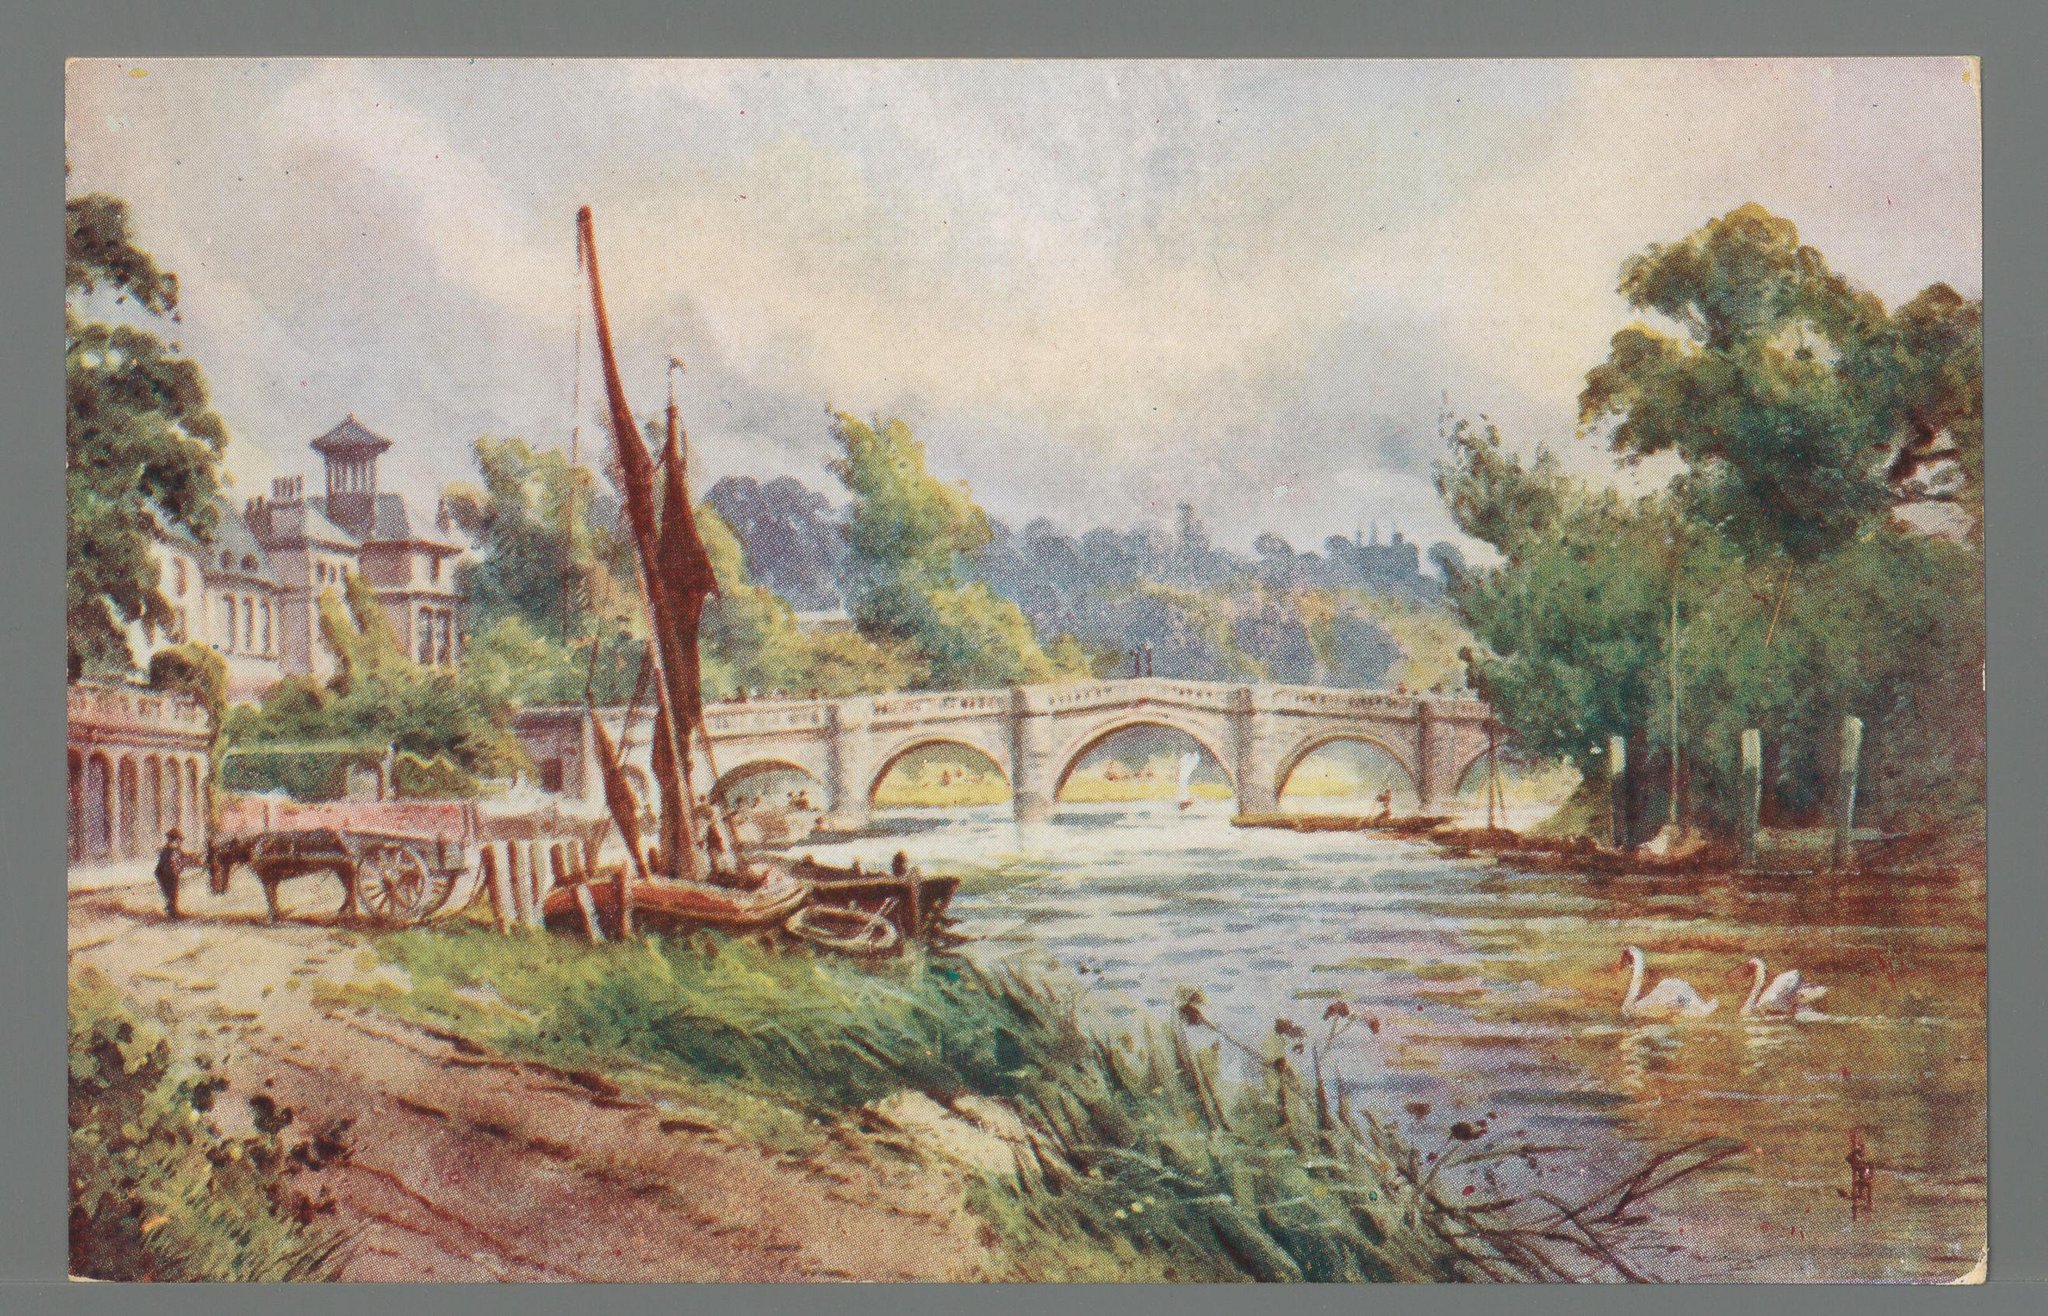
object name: ansichtkaart, prentbriefkaart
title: Richmond Bridge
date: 1902-1930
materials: cardboard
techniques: color autotype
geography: richmond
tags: canals, waters (in city), bridge in city across river, canal, etc., thames